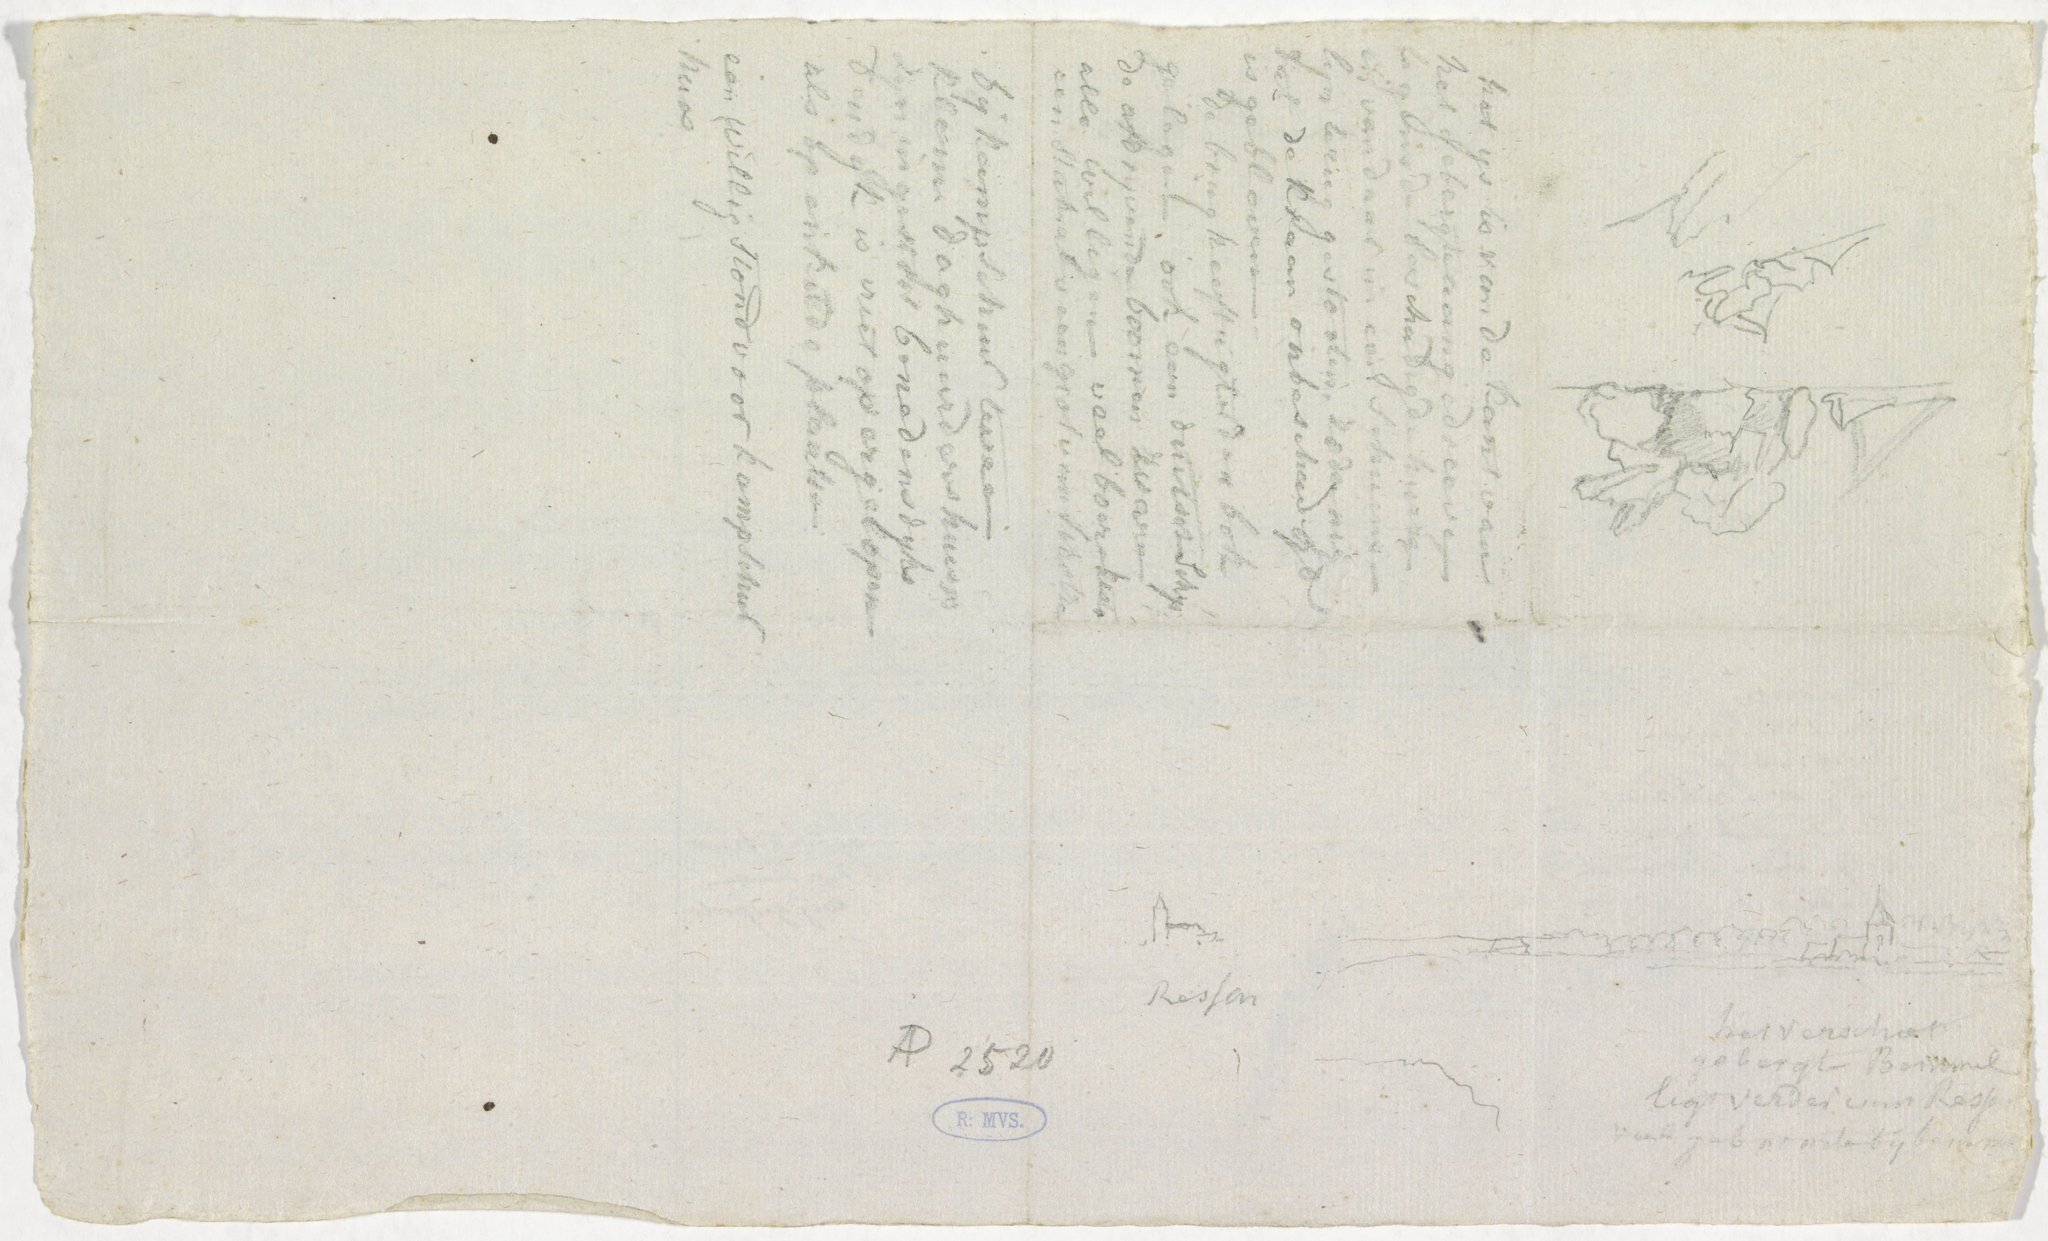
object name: drawing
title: Schetsen van de watersnood, 1809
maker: cornelis van hardenbergh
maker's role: draughtsman, painter, print maker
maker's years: 1755-1843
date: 1809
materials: paper, pencil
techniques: writing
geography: netherlands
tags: dike-break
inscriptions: collector's mark: Lugt 2228, inscription: ‘het ijs is van de kant van het ...’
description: Onderdeel van een groep schetsen met een handgeschreven lijst van tekeningen van de watersnood in Gelderland in januari-februari 1809 door Cornelis van Hardenbergh. Deze schets van het ijs is misschien gebruikt voor de prent FMH 5754a/9 (zie: RP-P-OB-86.974).